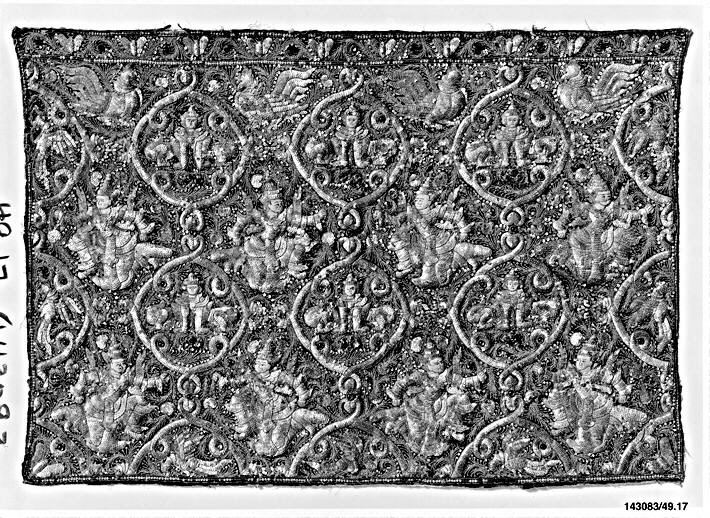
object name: hanging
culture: burmese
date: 1801-1833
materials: gold, paste, silk, silver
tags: mythical creatures